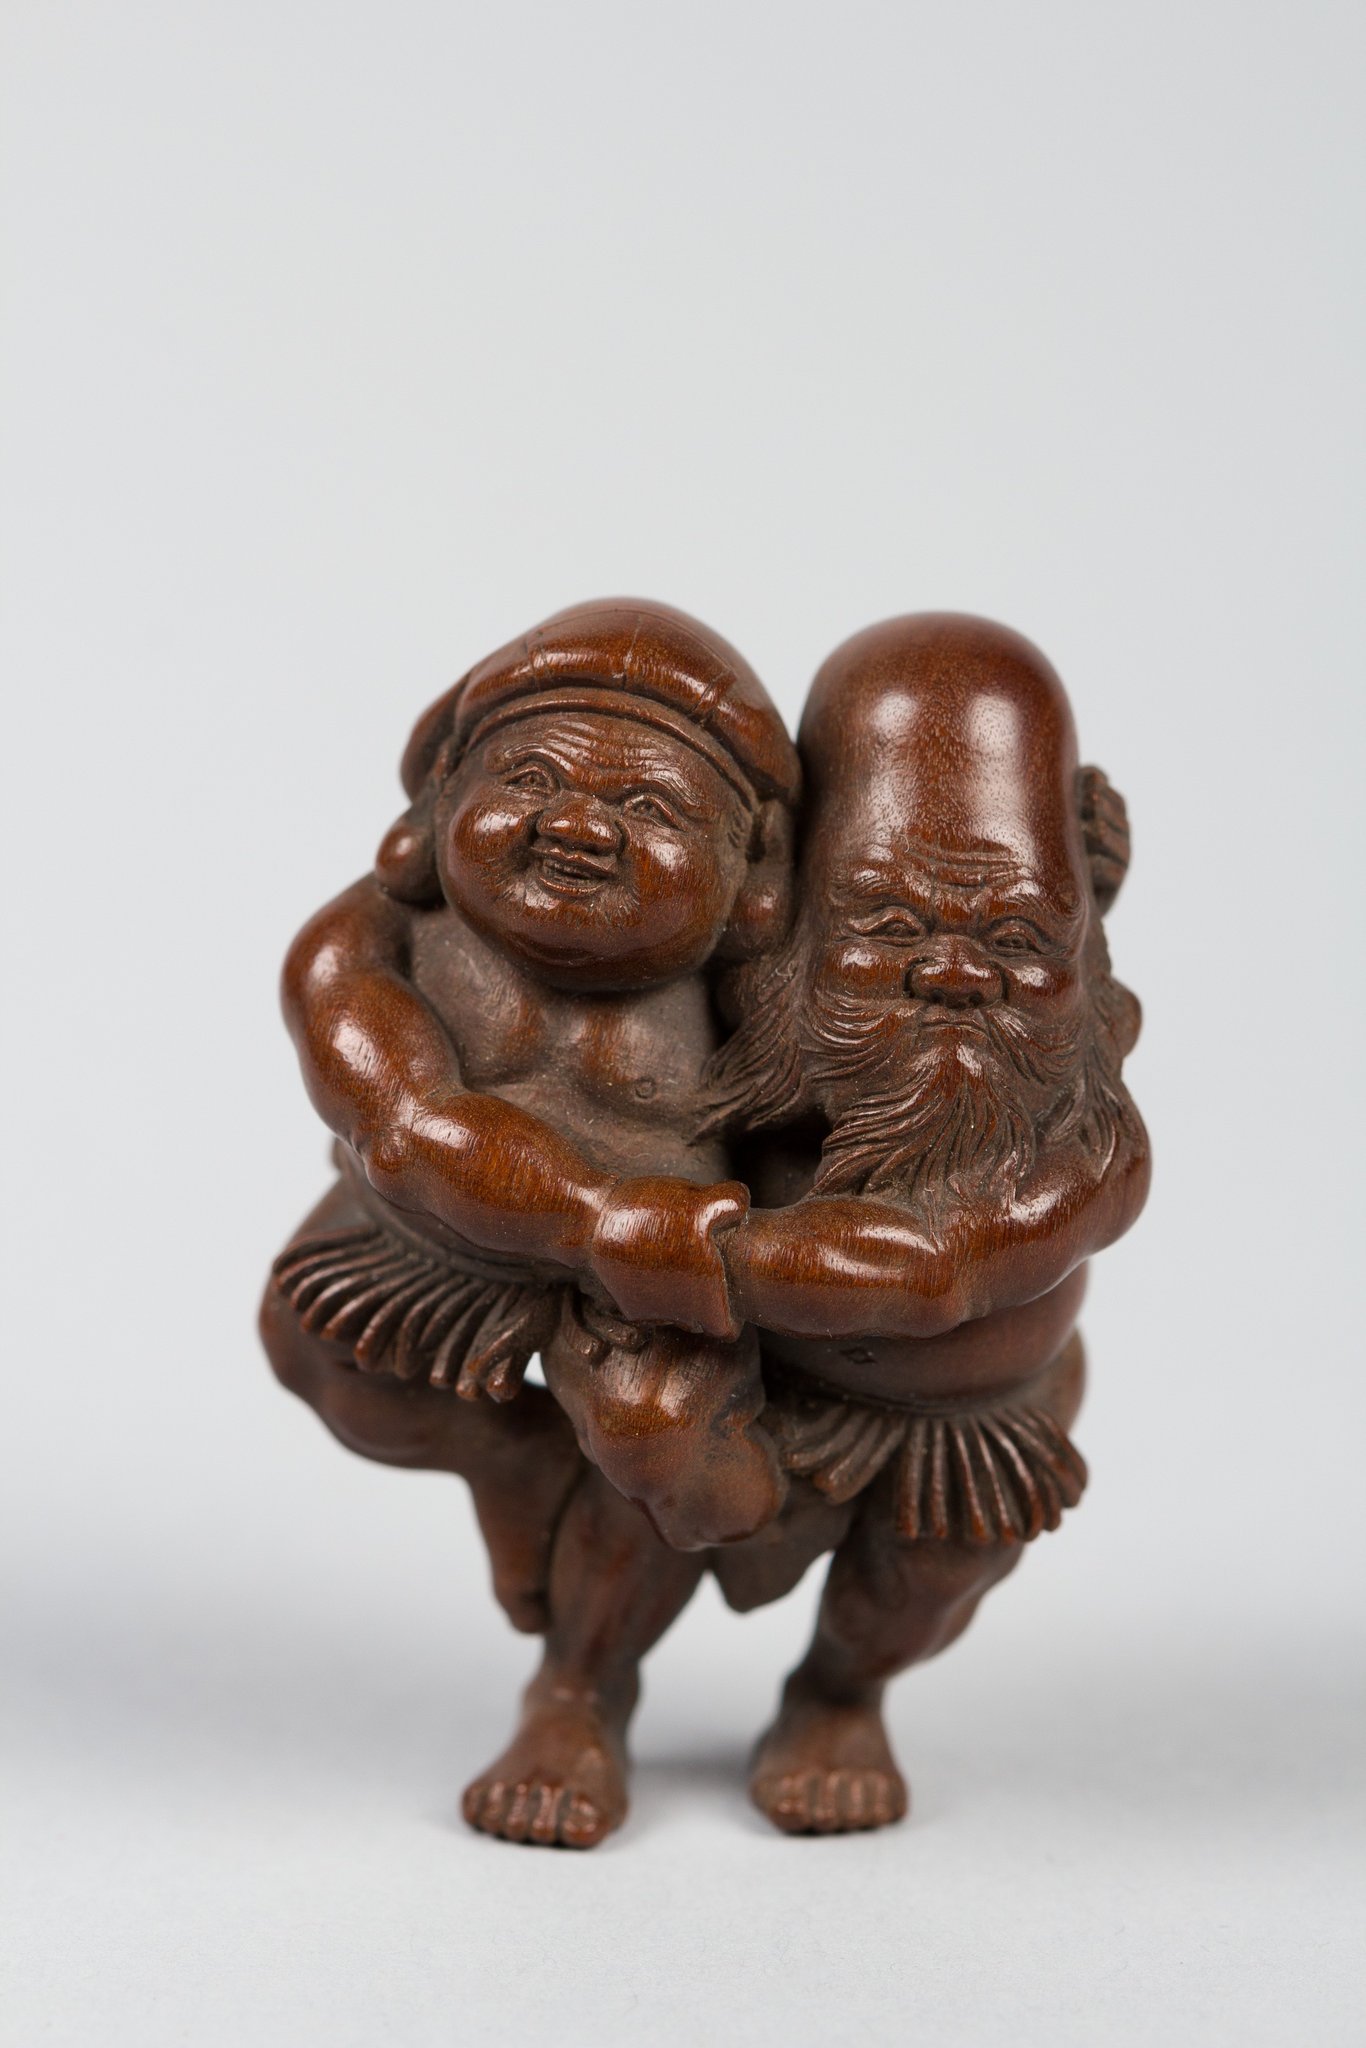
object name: netsuke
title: Netsuke of Two Figures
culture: japanese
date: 1801-1900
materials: wood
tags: men